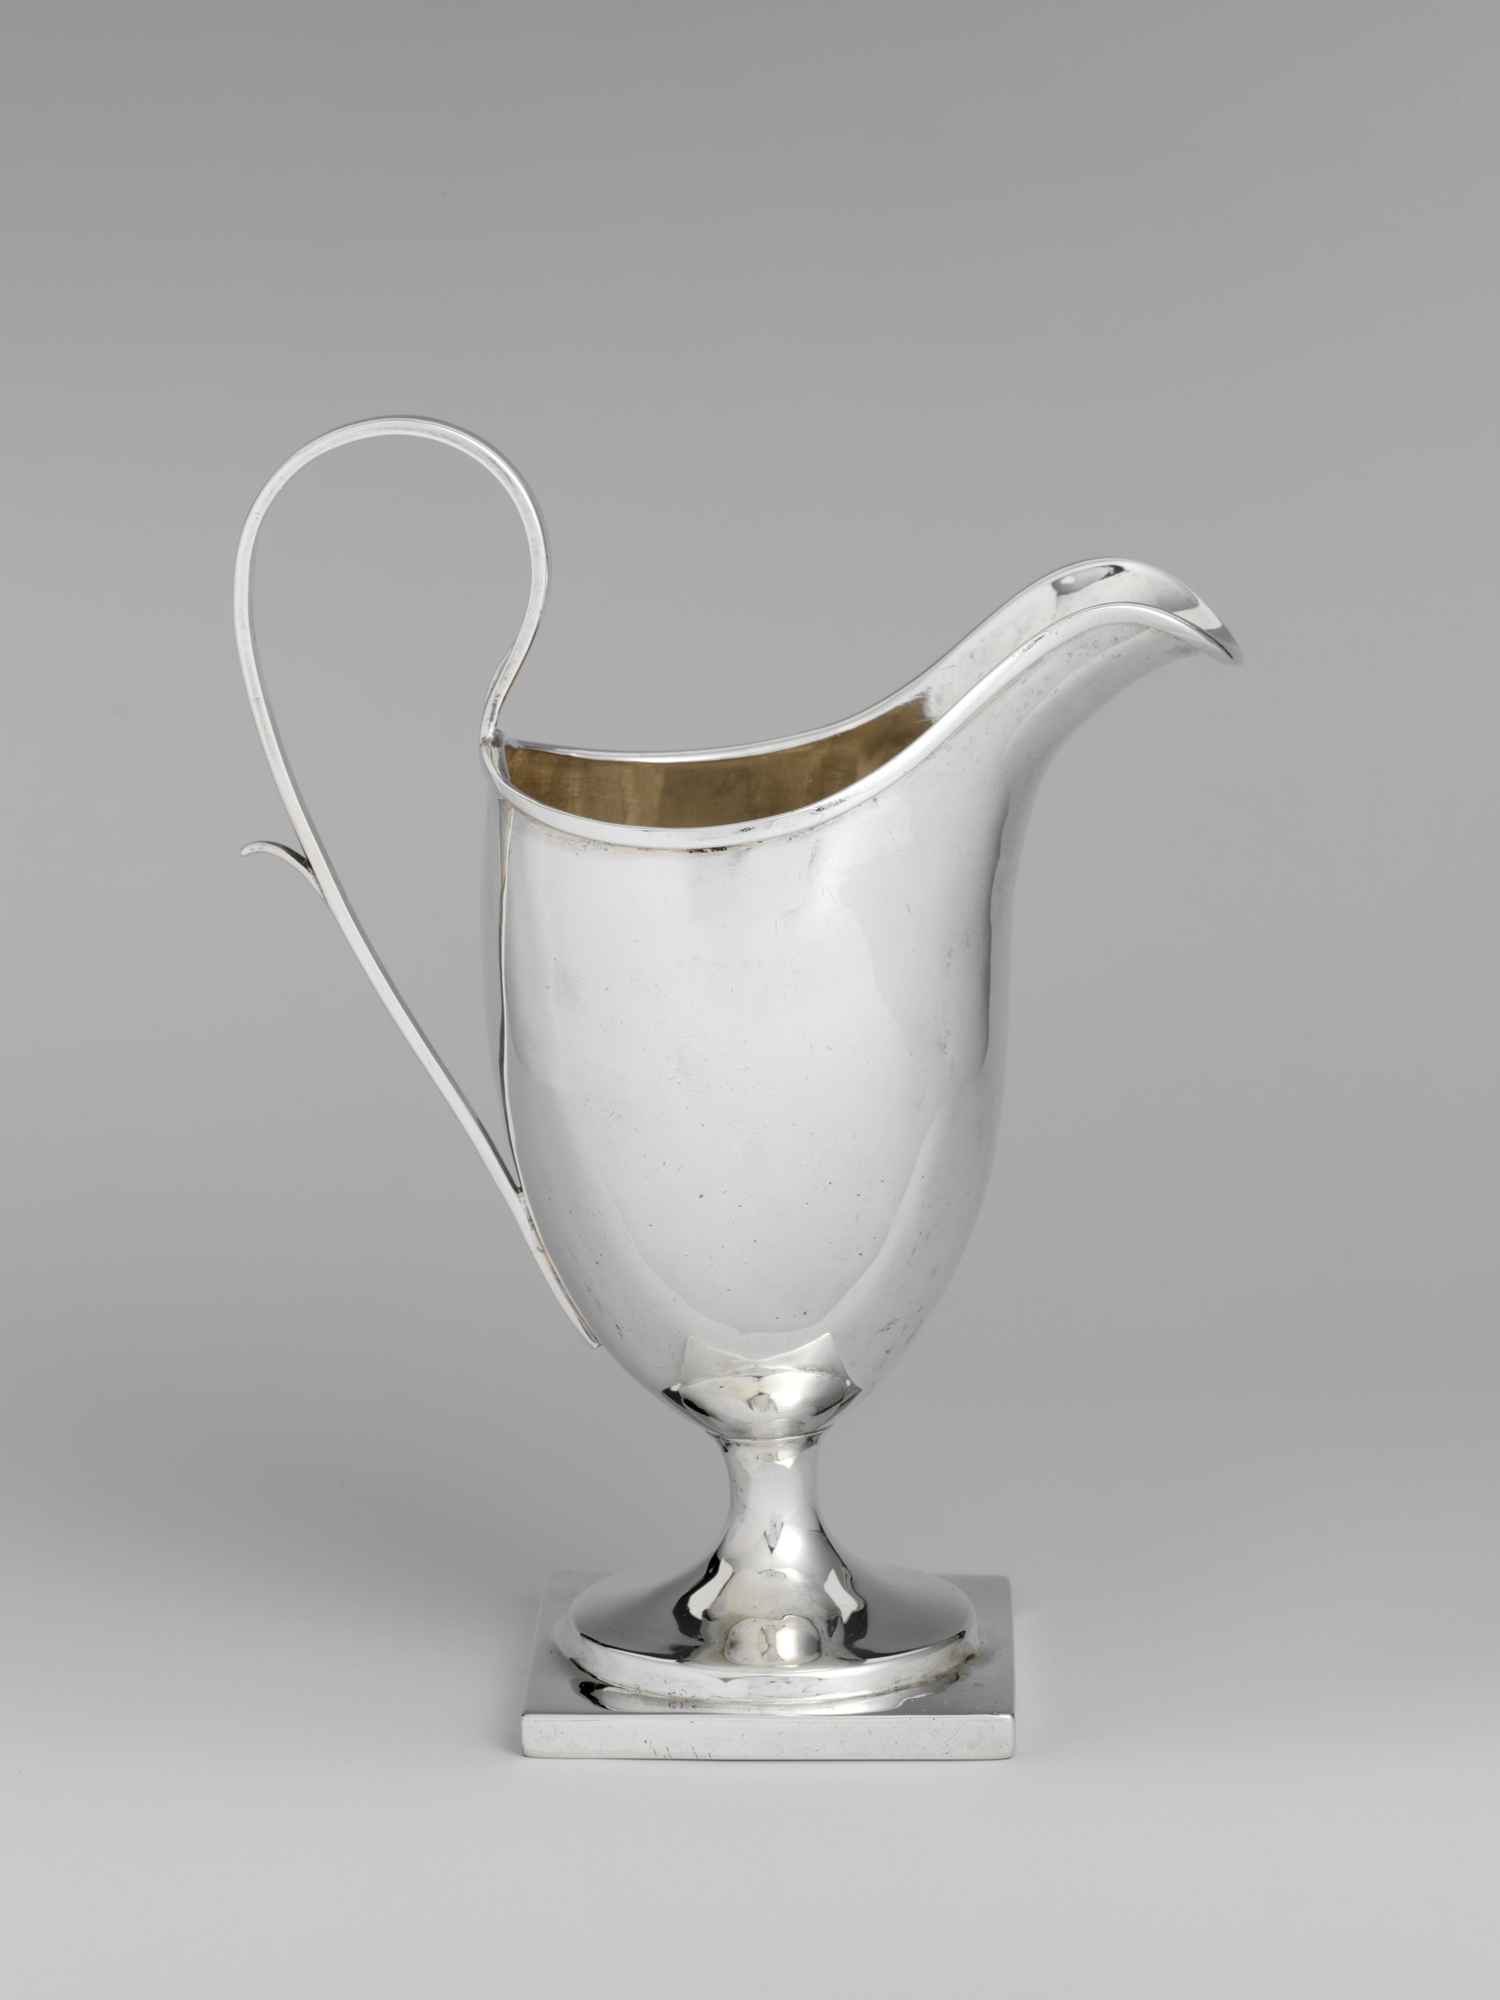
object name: cream pot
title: Creamer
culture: american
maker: james adam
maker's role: maker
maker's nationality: american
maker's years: 1755-1798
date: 1770-1810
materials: silver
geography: united states